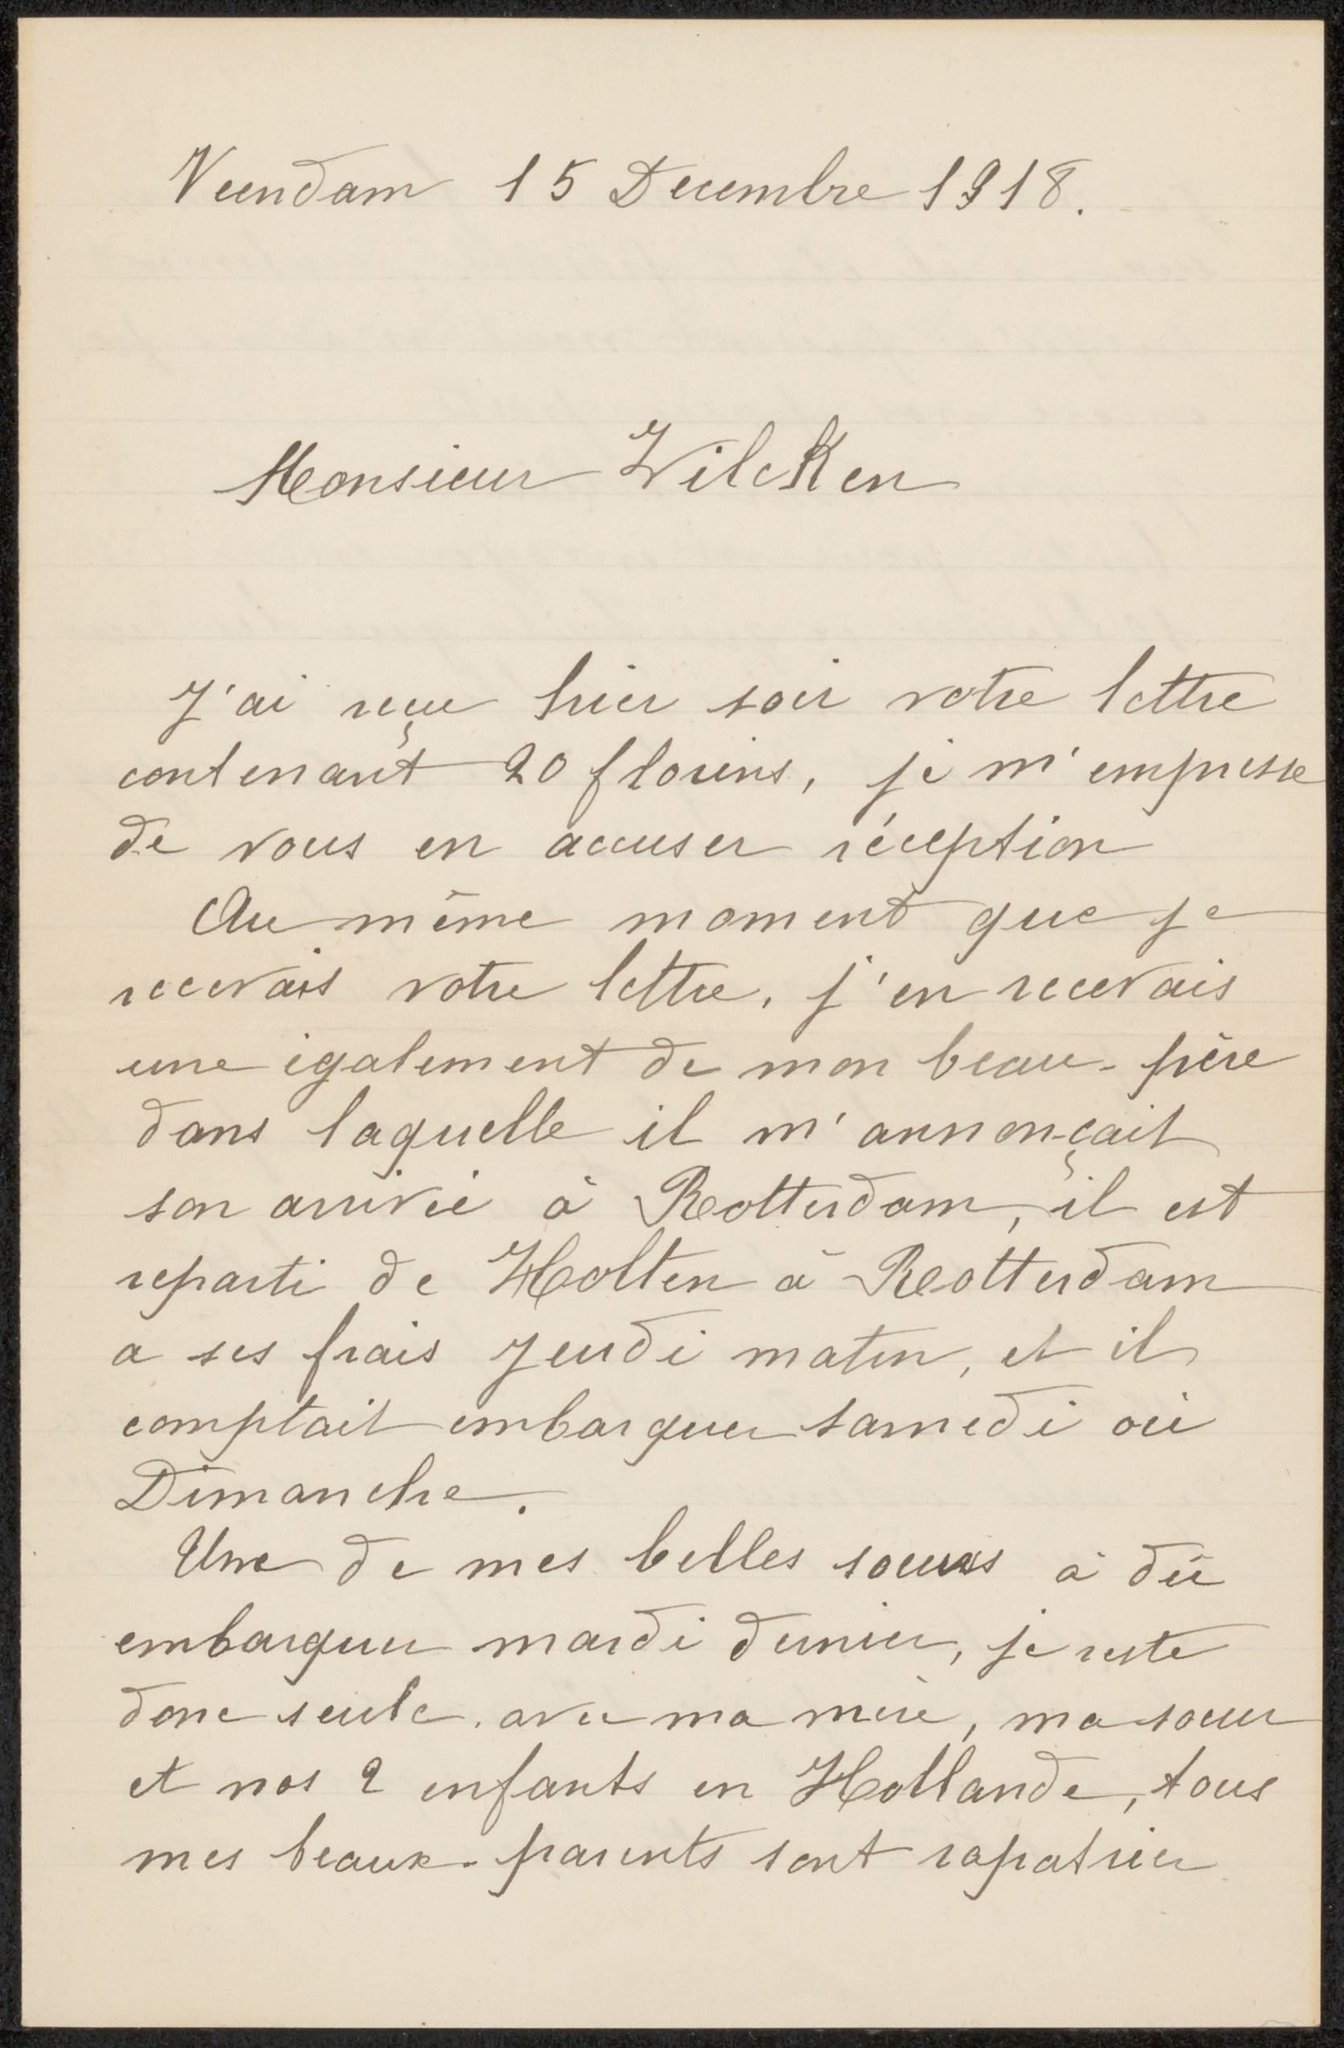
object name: letter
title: Brief aan Philip Zilcken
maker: mevrouw léon gernez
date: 1918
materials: ink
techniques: pen, writing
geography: veendam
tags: mevrouw jean buhot, the hague, draughtsman, philip zilcken, family life, money, rotterdam, france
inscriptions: collector's mark: ‘RPK’